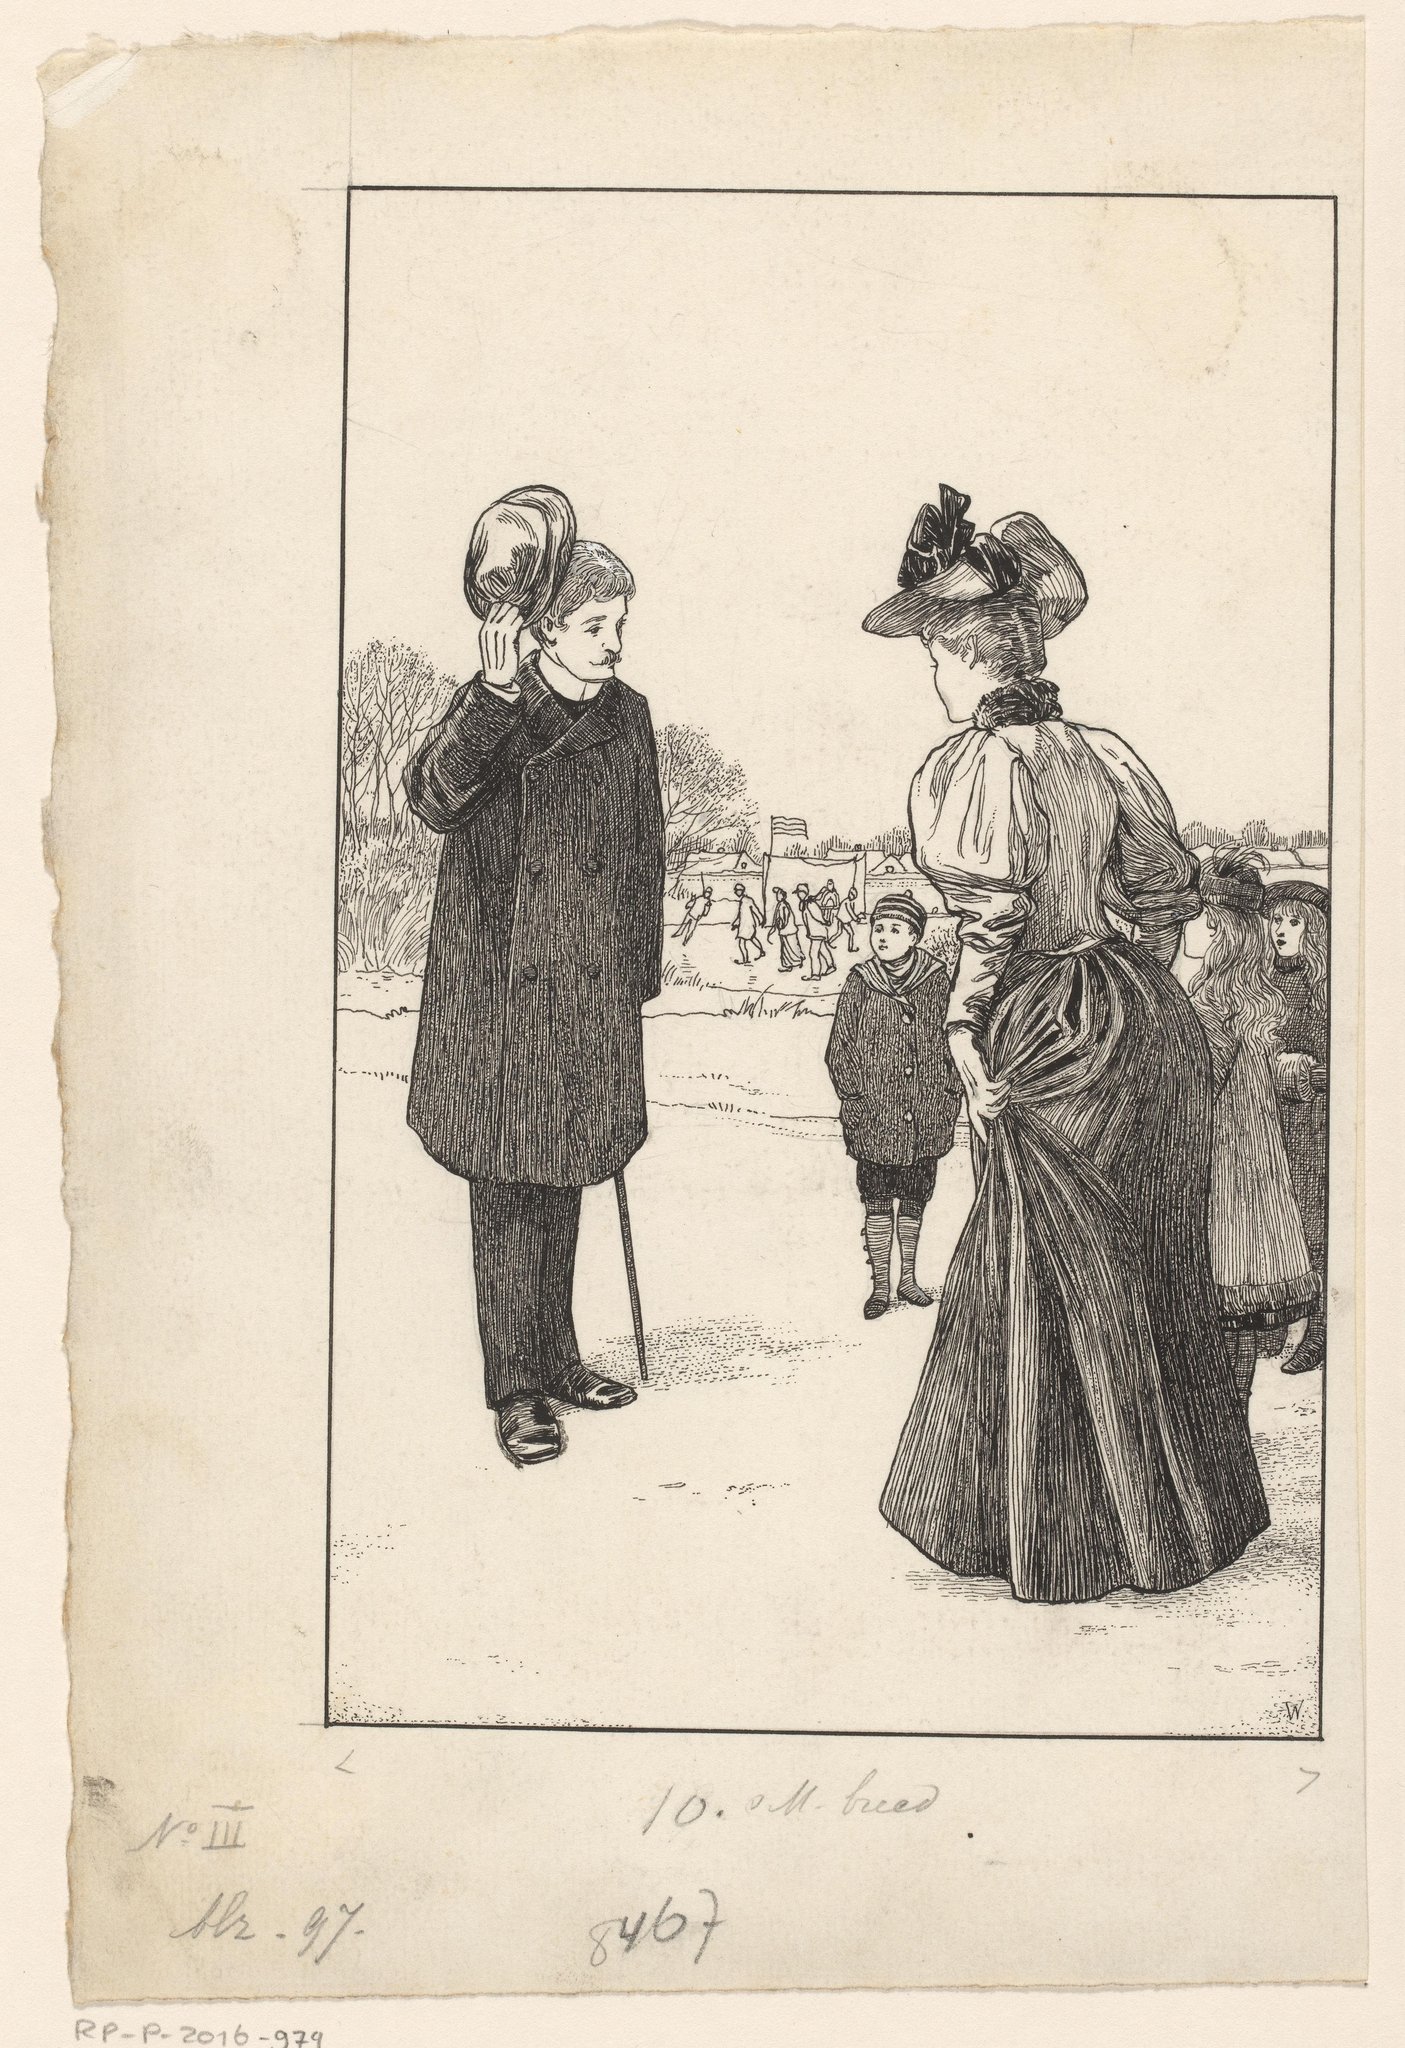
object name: boekillustratie ontwerp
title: Man neemt zijn hoed af voor een vrouw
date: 1870-1937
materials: paint, ink, paper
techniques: brush, printing block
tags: baring the head, lifting one's hat, skates (winter sports)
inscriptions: :, collector's mark: Lugt 2228, annotation: ‘No III/ blz. 97.’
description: In een landschap neemt een man met een wandelstok zijn hoed af voor een vrouw. Naast de vrouw staat een groep kinderen en in de achtergrond is een bevroren kanaal te zien waarop wordt geschaatst.